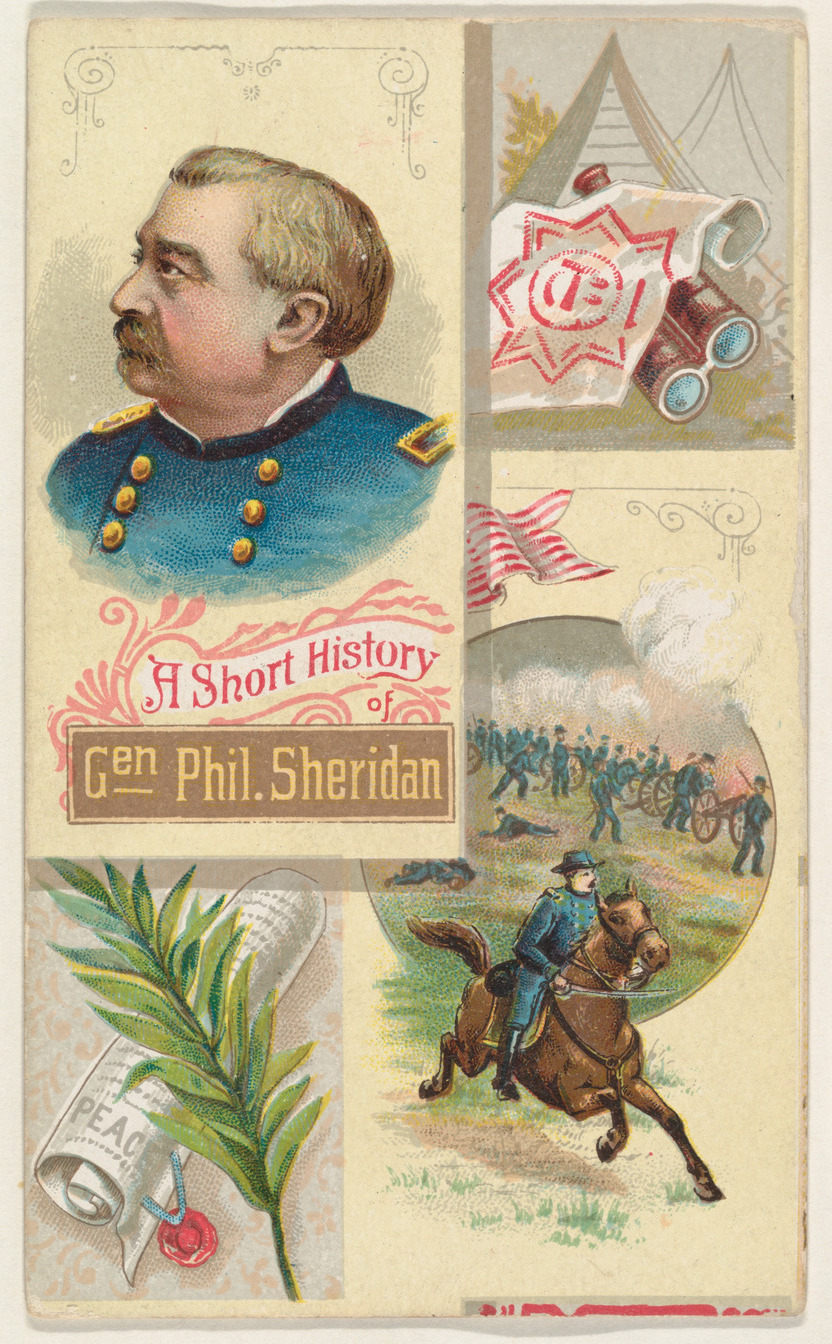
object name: print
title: A Short History of General Philip Sheridan, from the Histories of Generals series (N114) issued by W. Duke, Sons & Co. to promote Honest Long Cut Smoking and Chewing Tobacco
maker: w. duke, sons & co.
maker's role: publisher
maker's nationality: american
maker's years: 1870-1920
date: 1888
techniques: color lithograph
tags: cannons,men,horses,generals